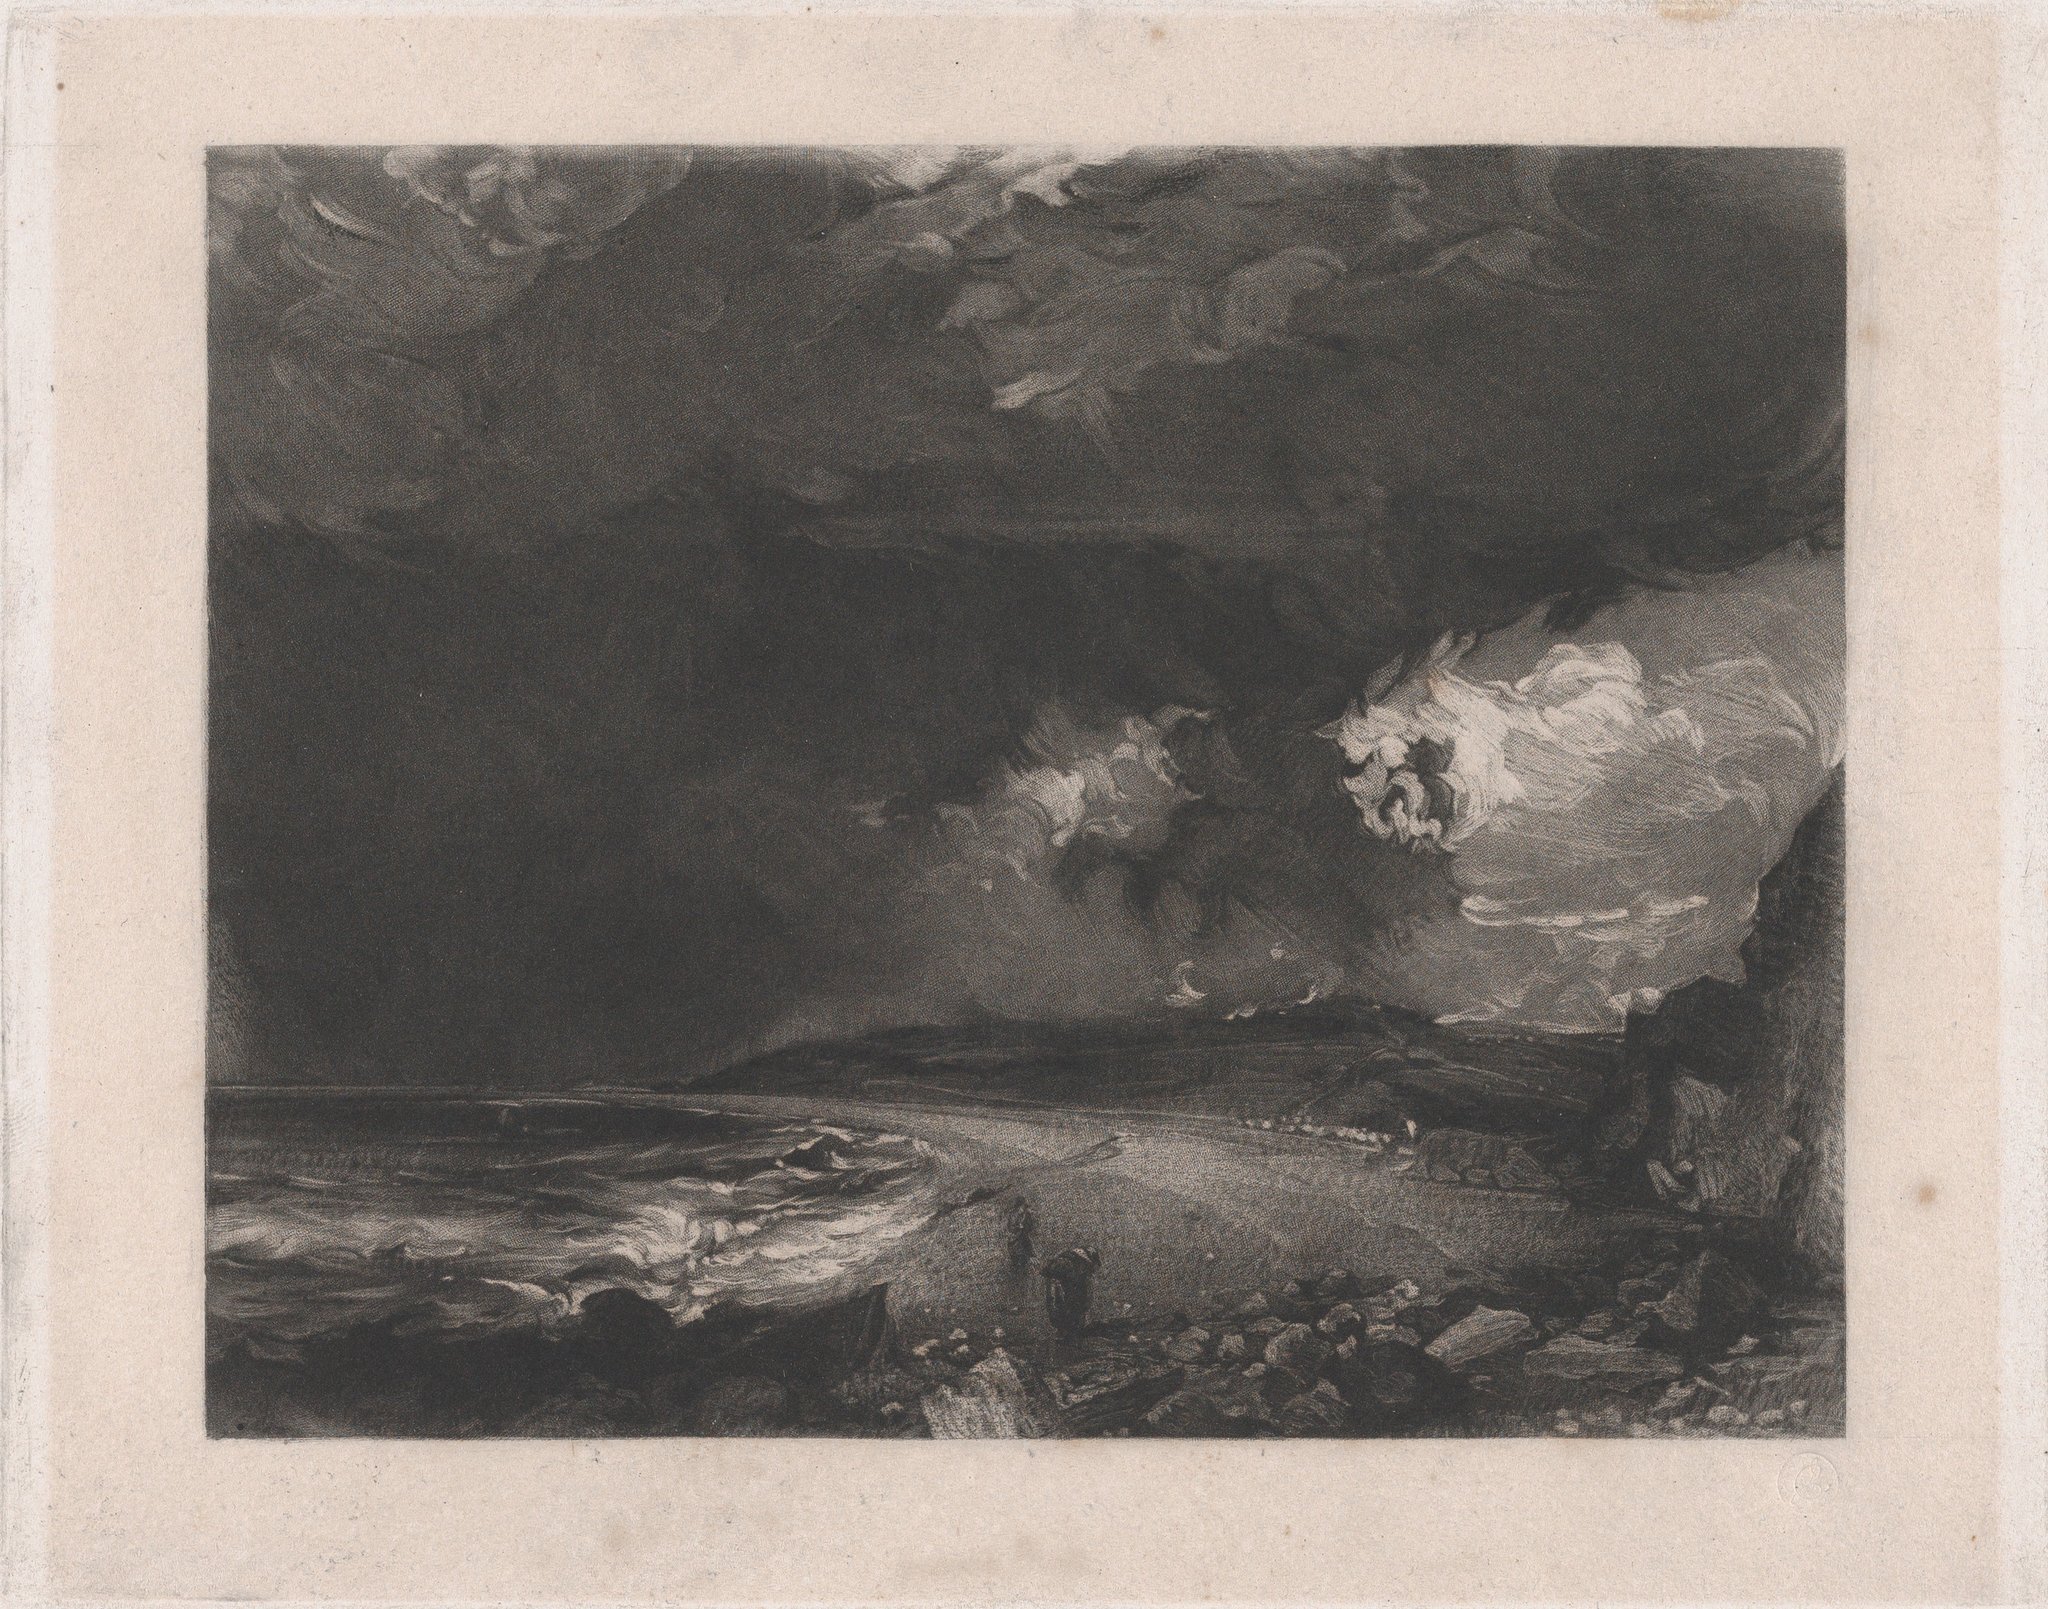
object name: print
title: Weymouth Bay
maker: david lucas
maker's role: artist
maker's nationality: british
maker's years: 1802-1881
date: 1830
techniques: mezzotint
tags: seascapes